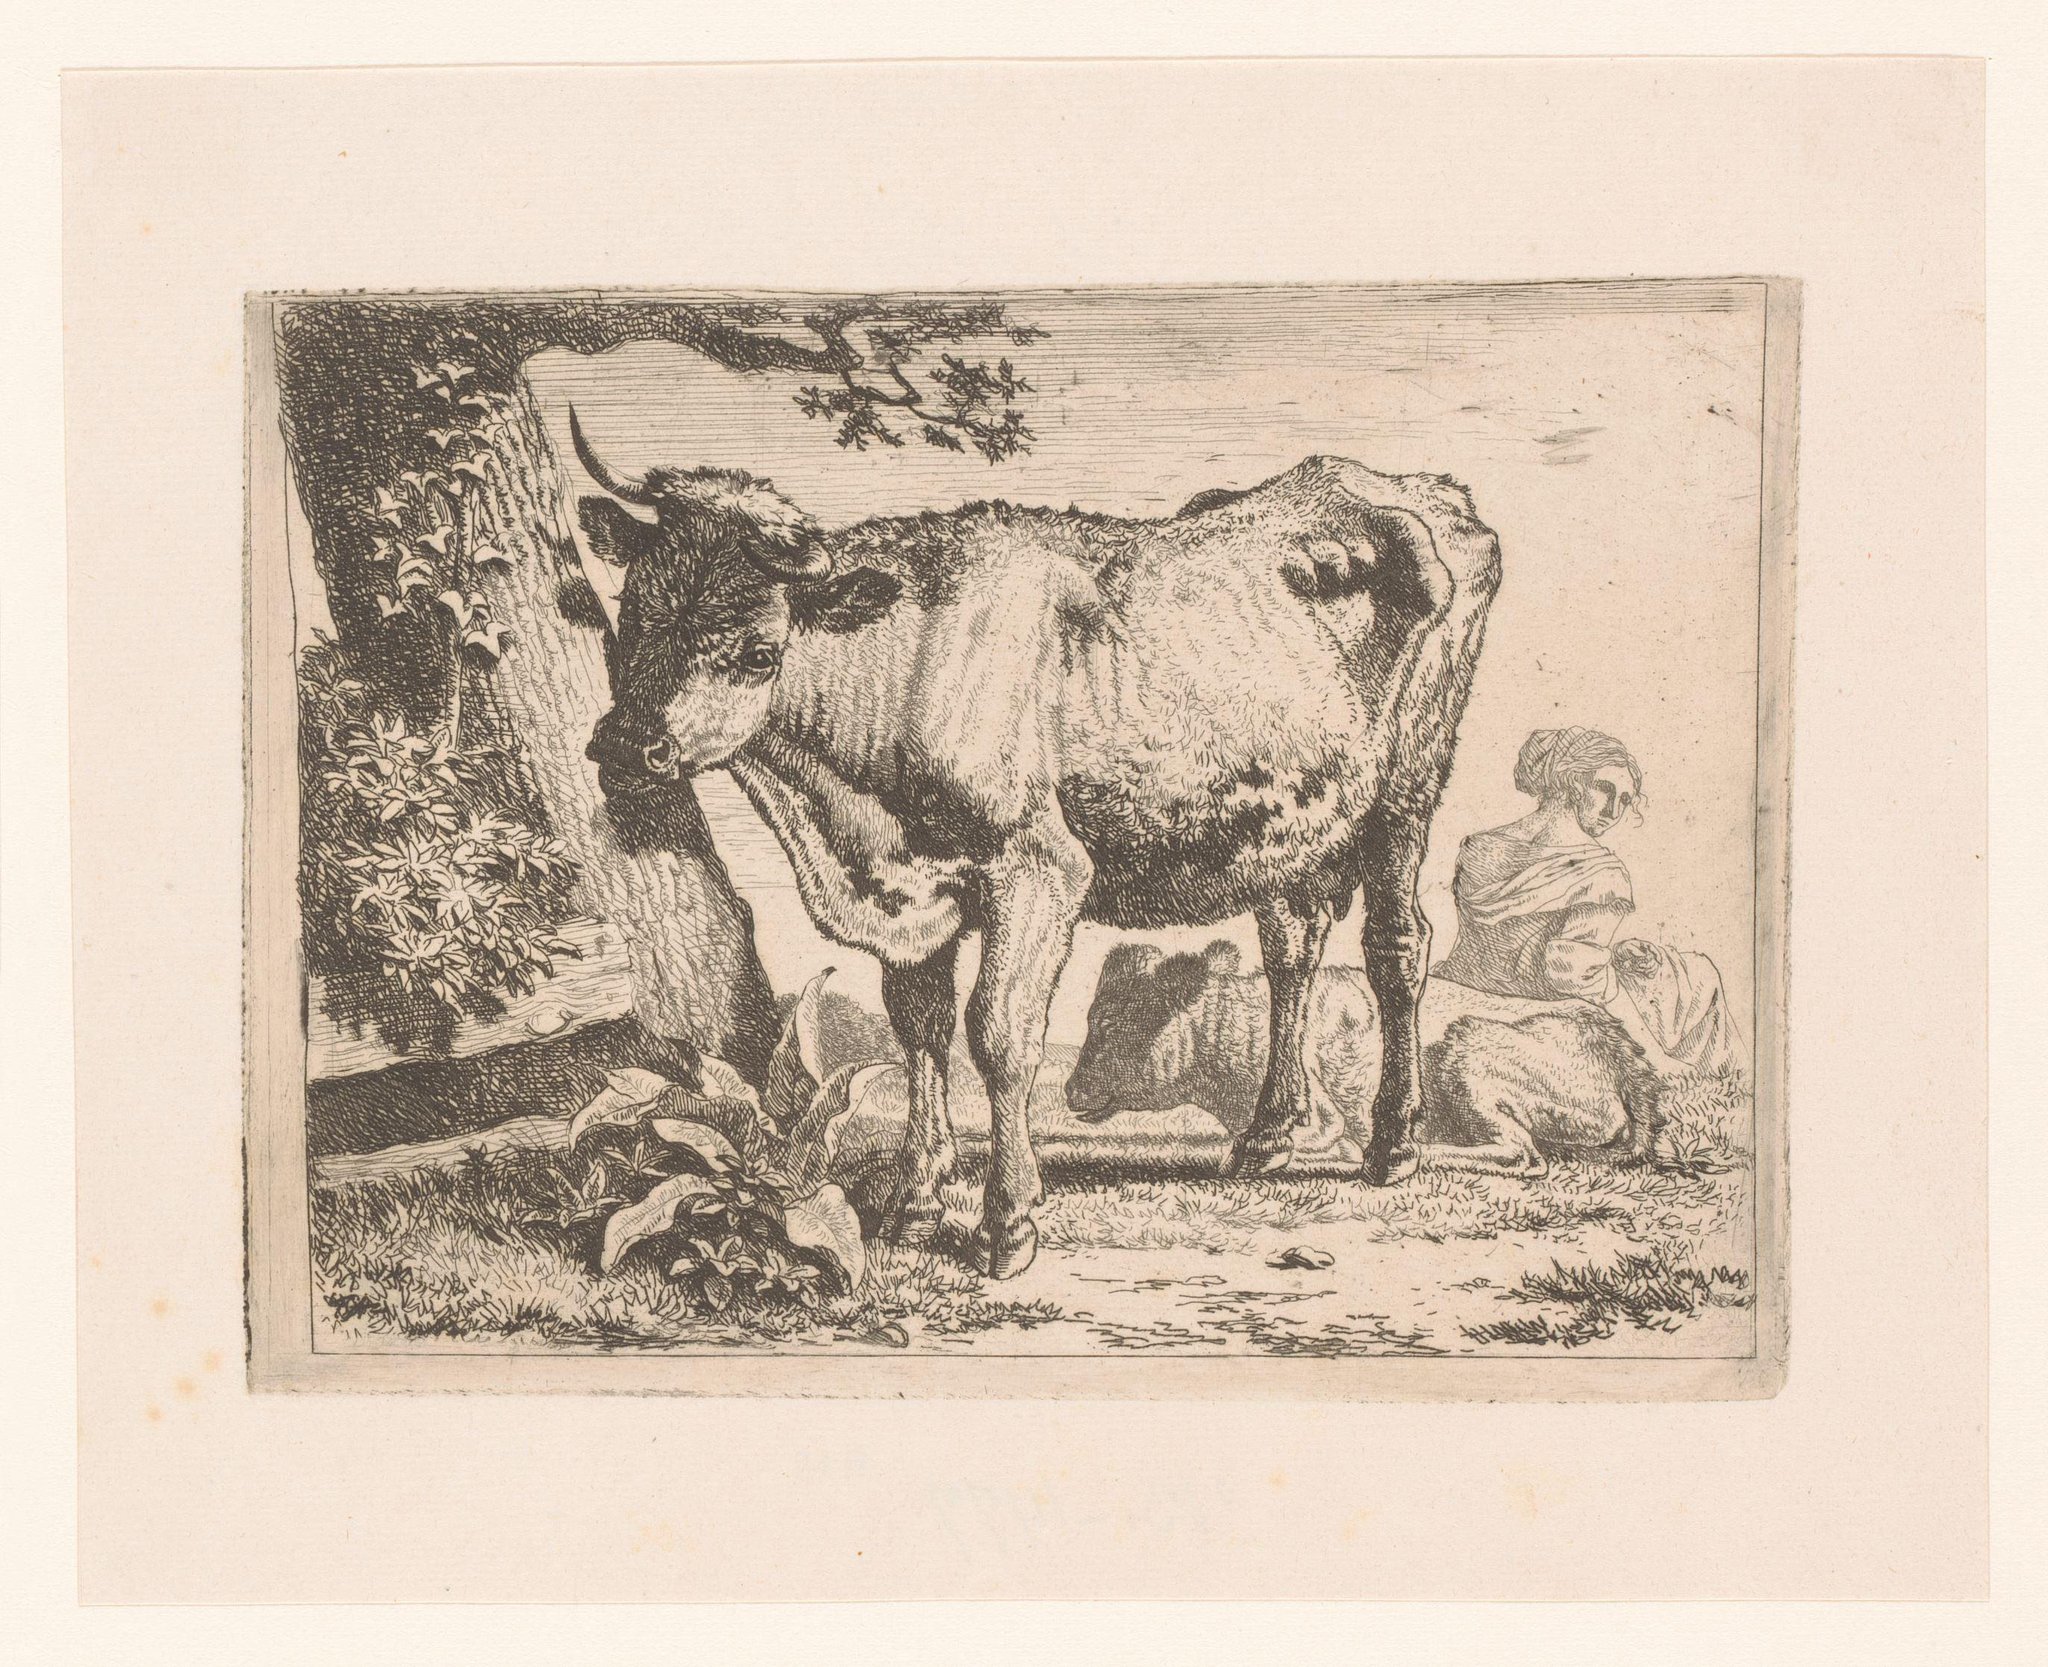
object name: print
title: Vrouw zittend bij een koe en haar kalf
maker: jean louis demarne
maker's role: draughtsman, painter, print maker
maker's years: 1752-1829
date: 1762-1829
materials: paper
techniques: etching, intaglio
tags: cow, adult woman, calf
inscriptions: collector's mark: Lugt 2228, collector's mark: Lugt 1485